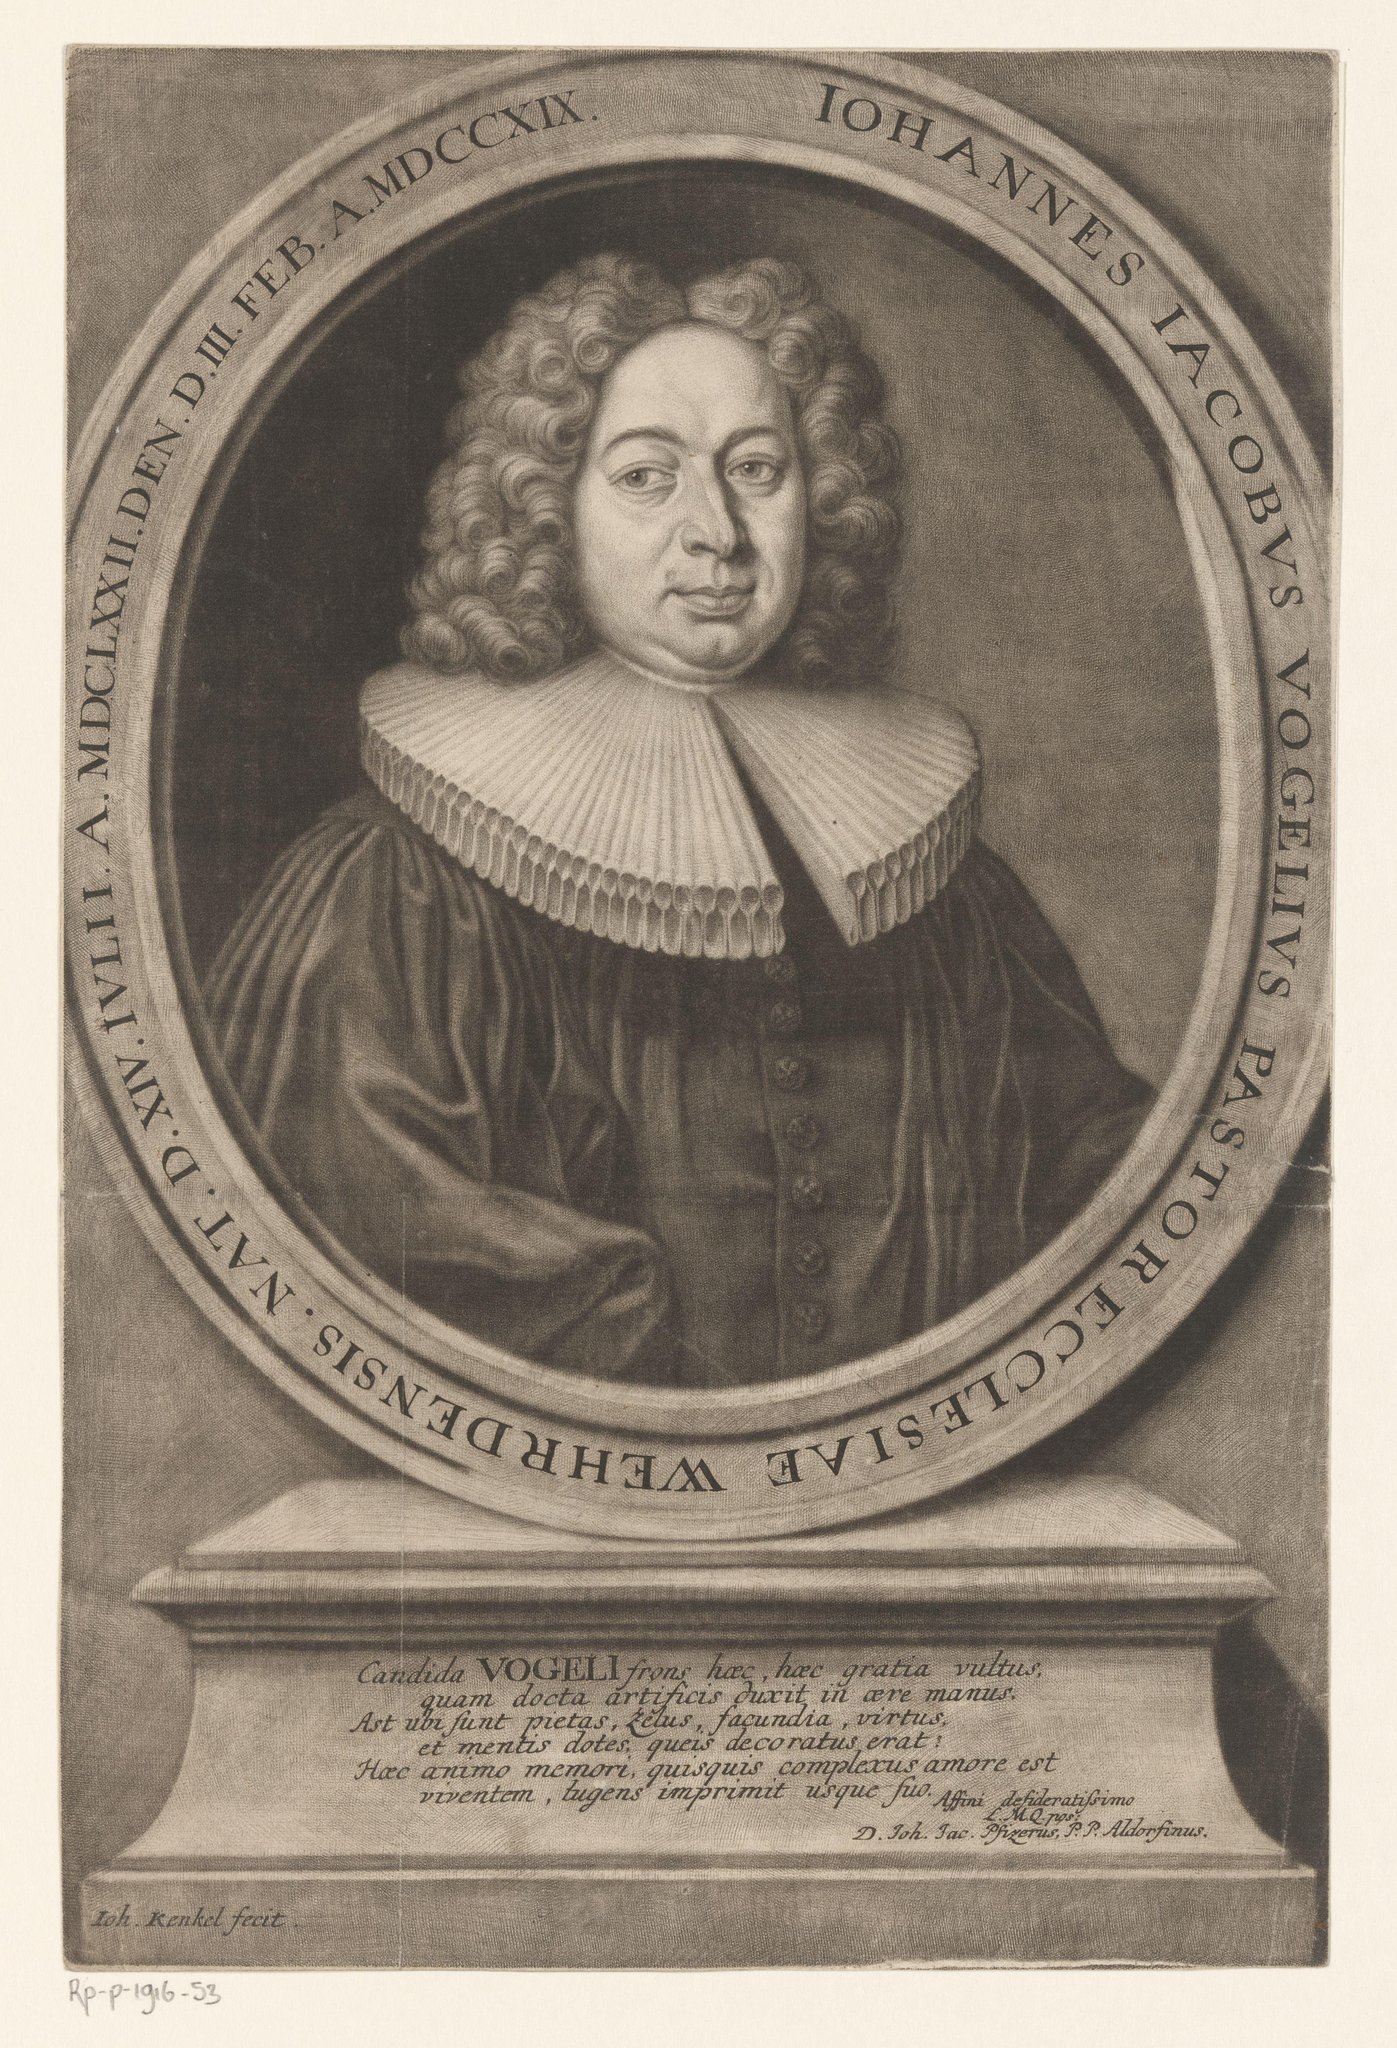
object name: print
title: Portret van Johann Jacob Vogel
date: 1719-1722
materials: paper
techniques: mezzotint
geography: altdorf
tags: historical persons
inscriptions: collector's mark: Lugt 2228